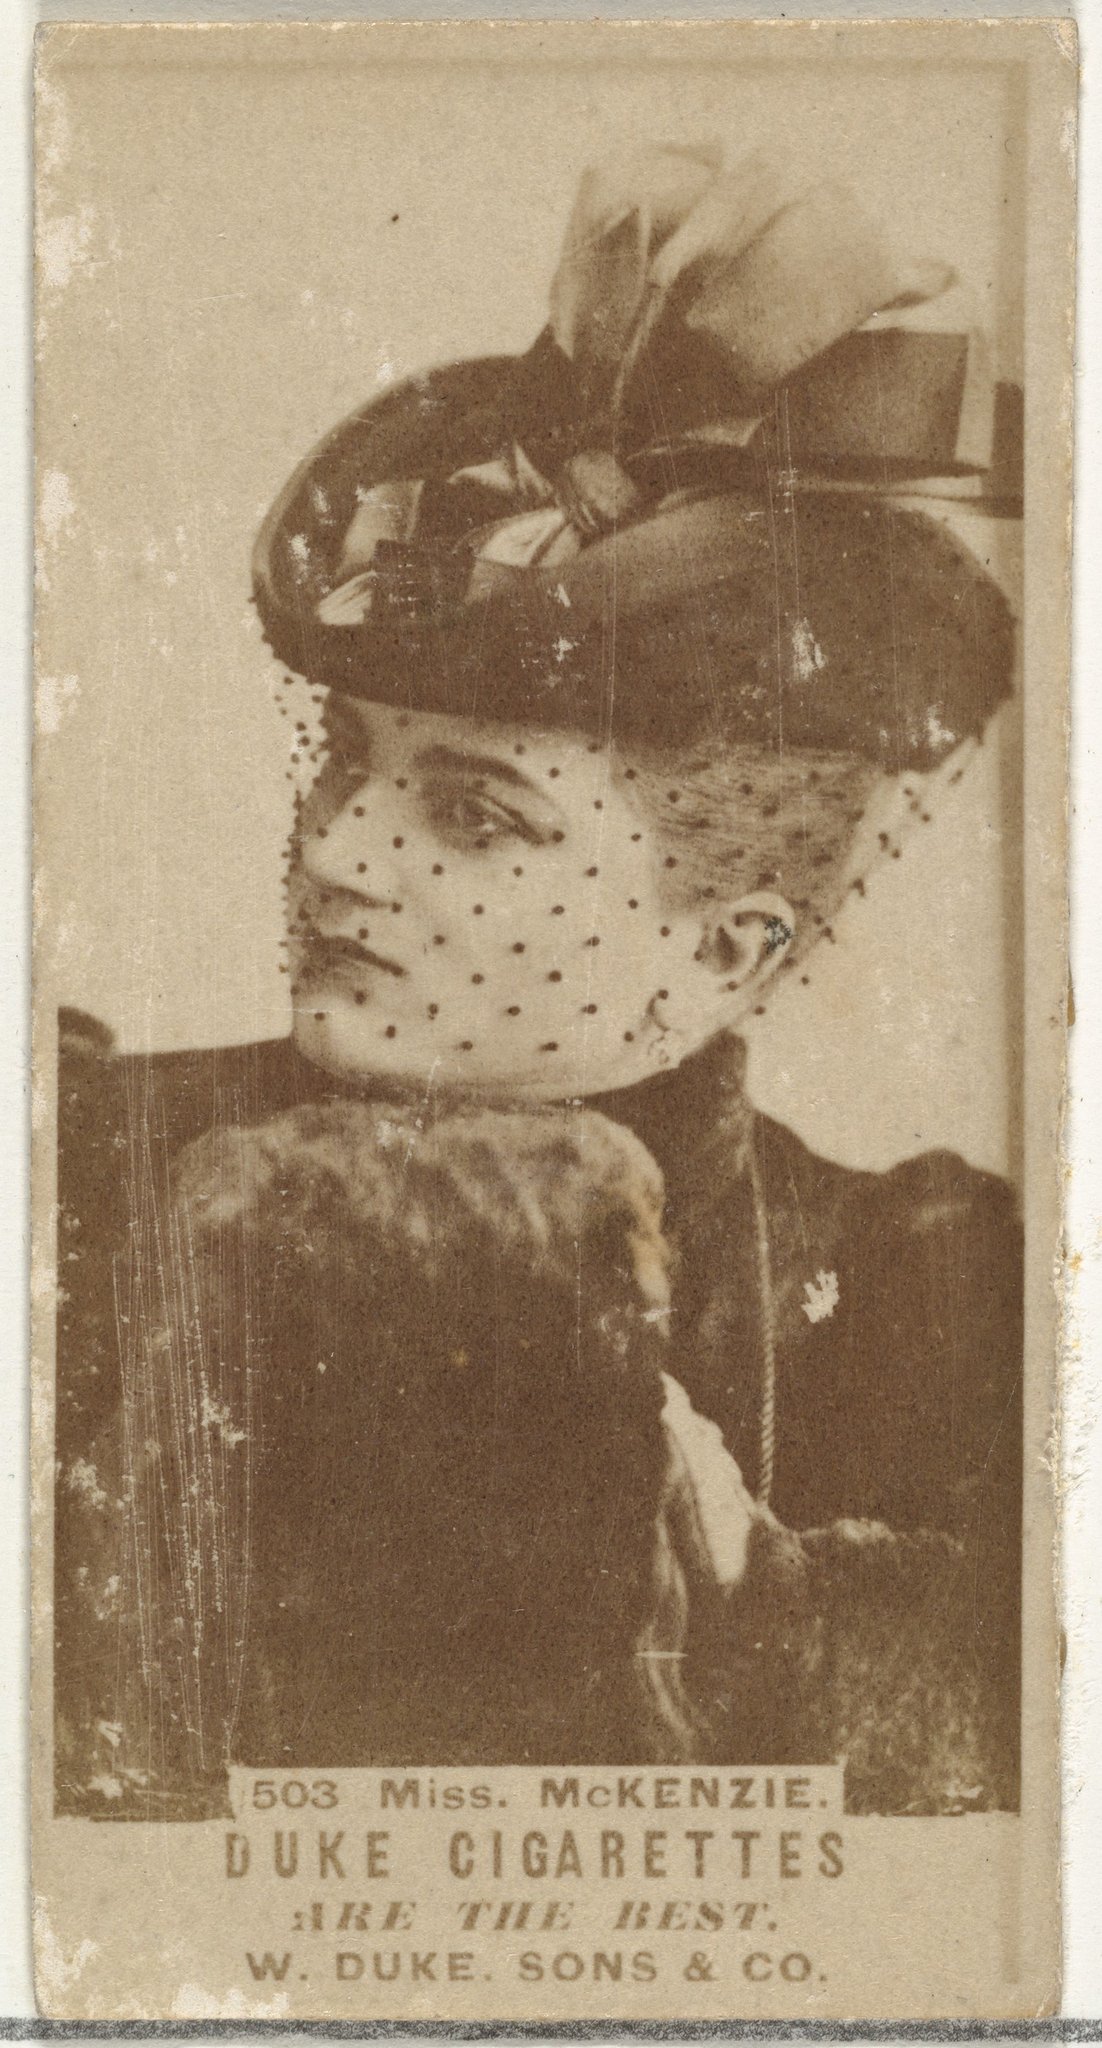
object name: photograph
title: Card Number 503, Miss McKenzie, from the Actors and Actresses series (N145-7) issued by Duke Sons & Co. to promote Duke Cigarettes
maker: w. duke, sons & co.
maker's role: publisher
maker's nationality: american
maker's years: 1870-1920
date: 1880-1889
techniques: albumen silver print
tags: portraits,women,actresses